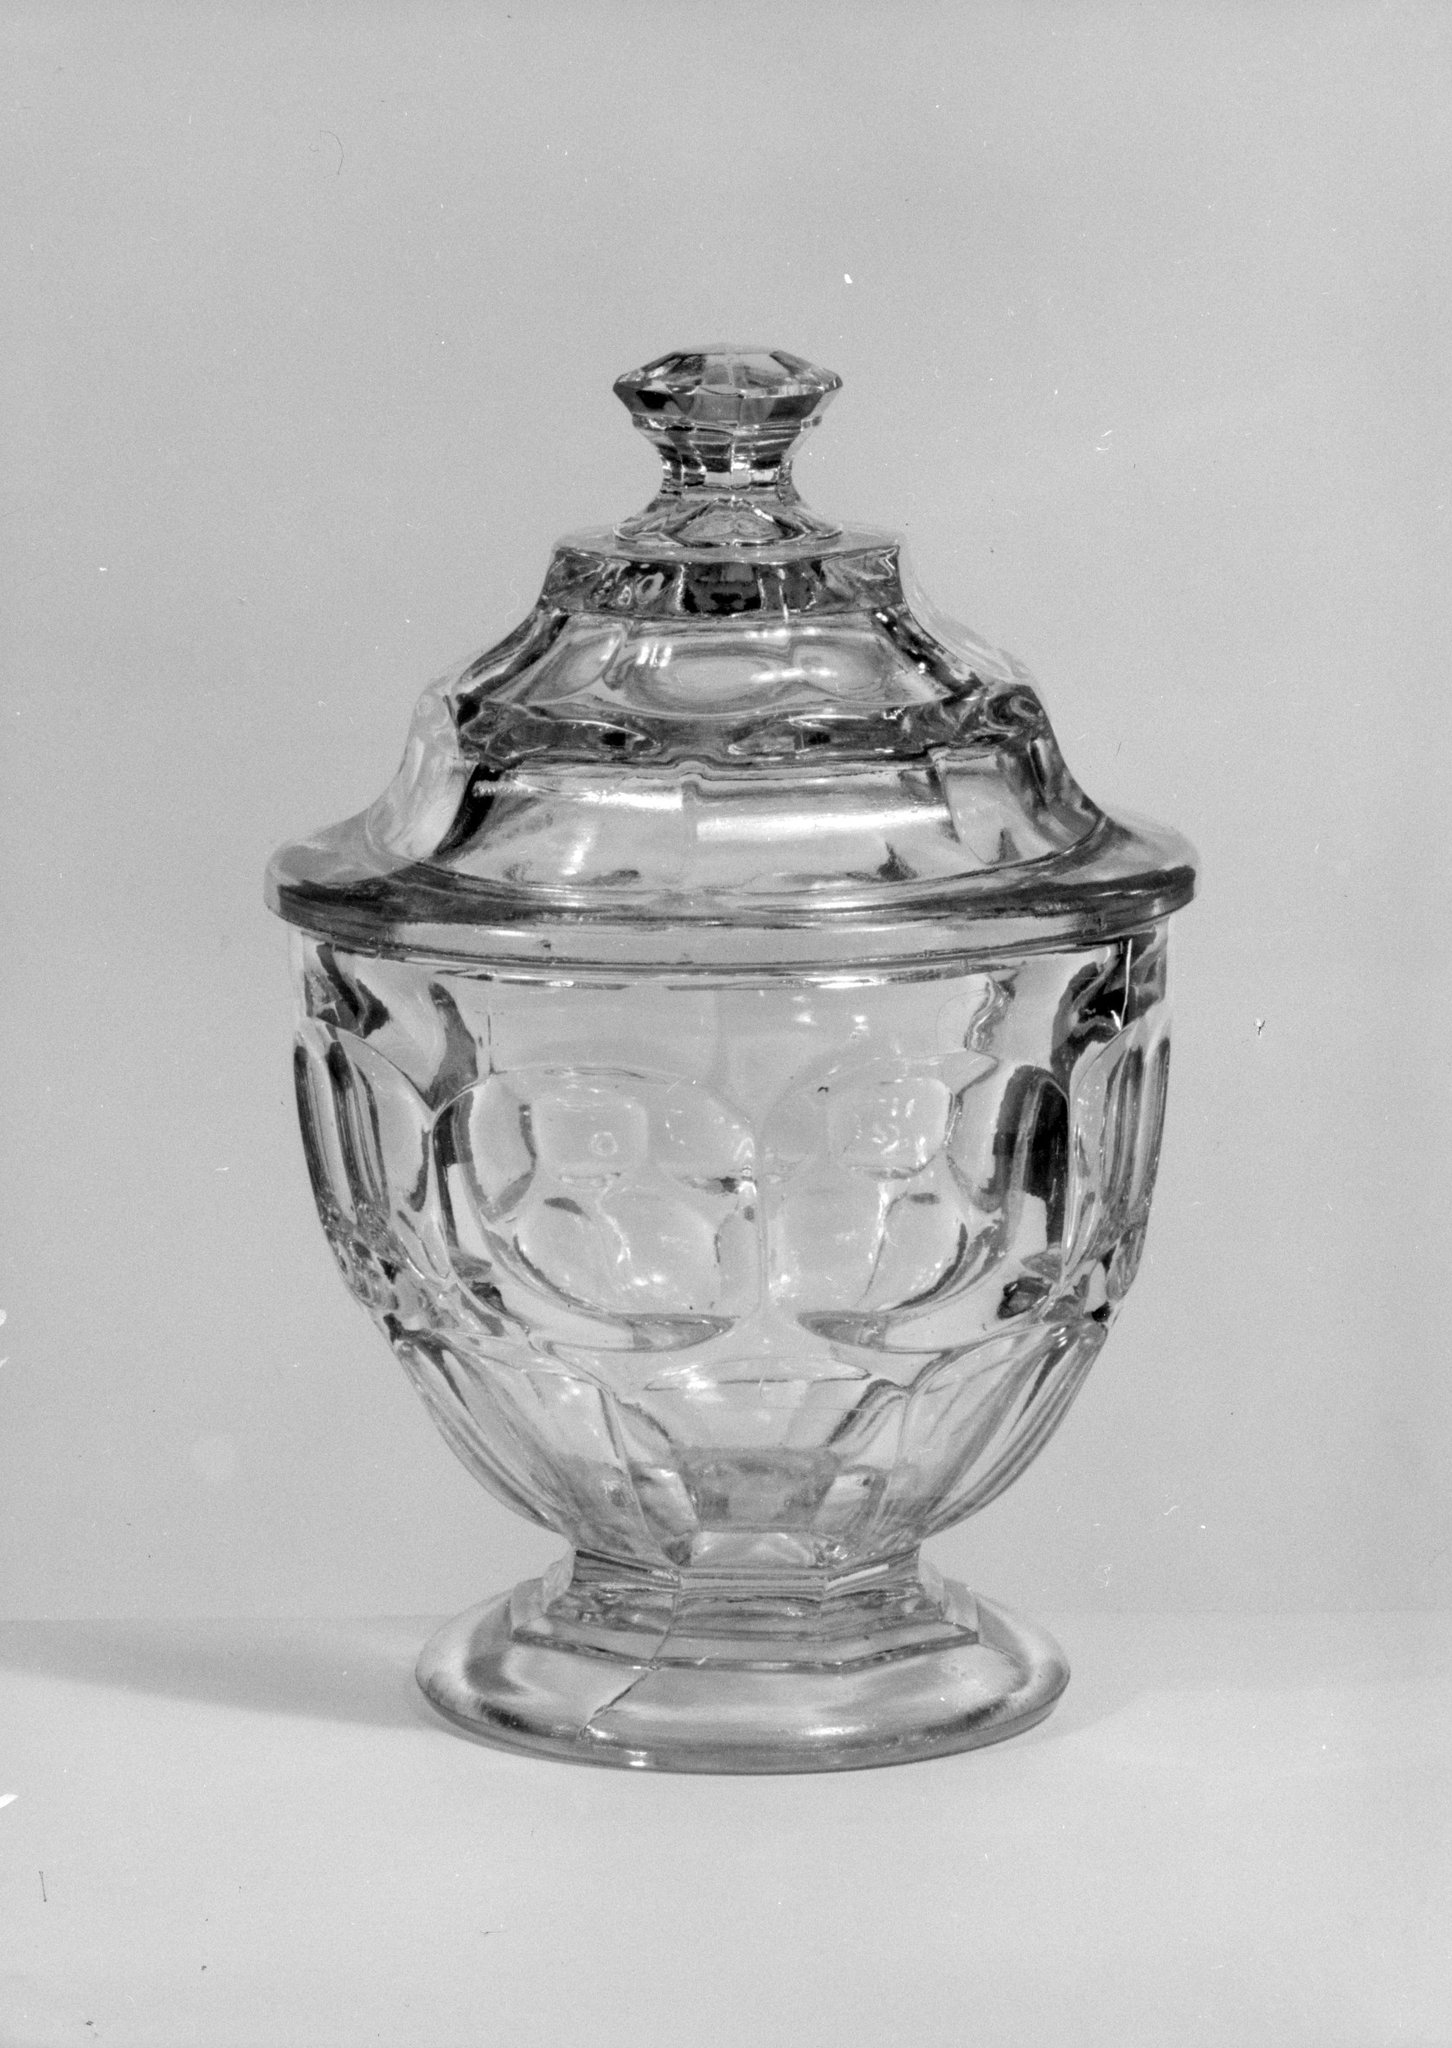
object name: sugar bowl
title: Covered Sugar Bowl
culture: american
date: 1830-1870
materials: glass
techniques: pressed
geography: united states